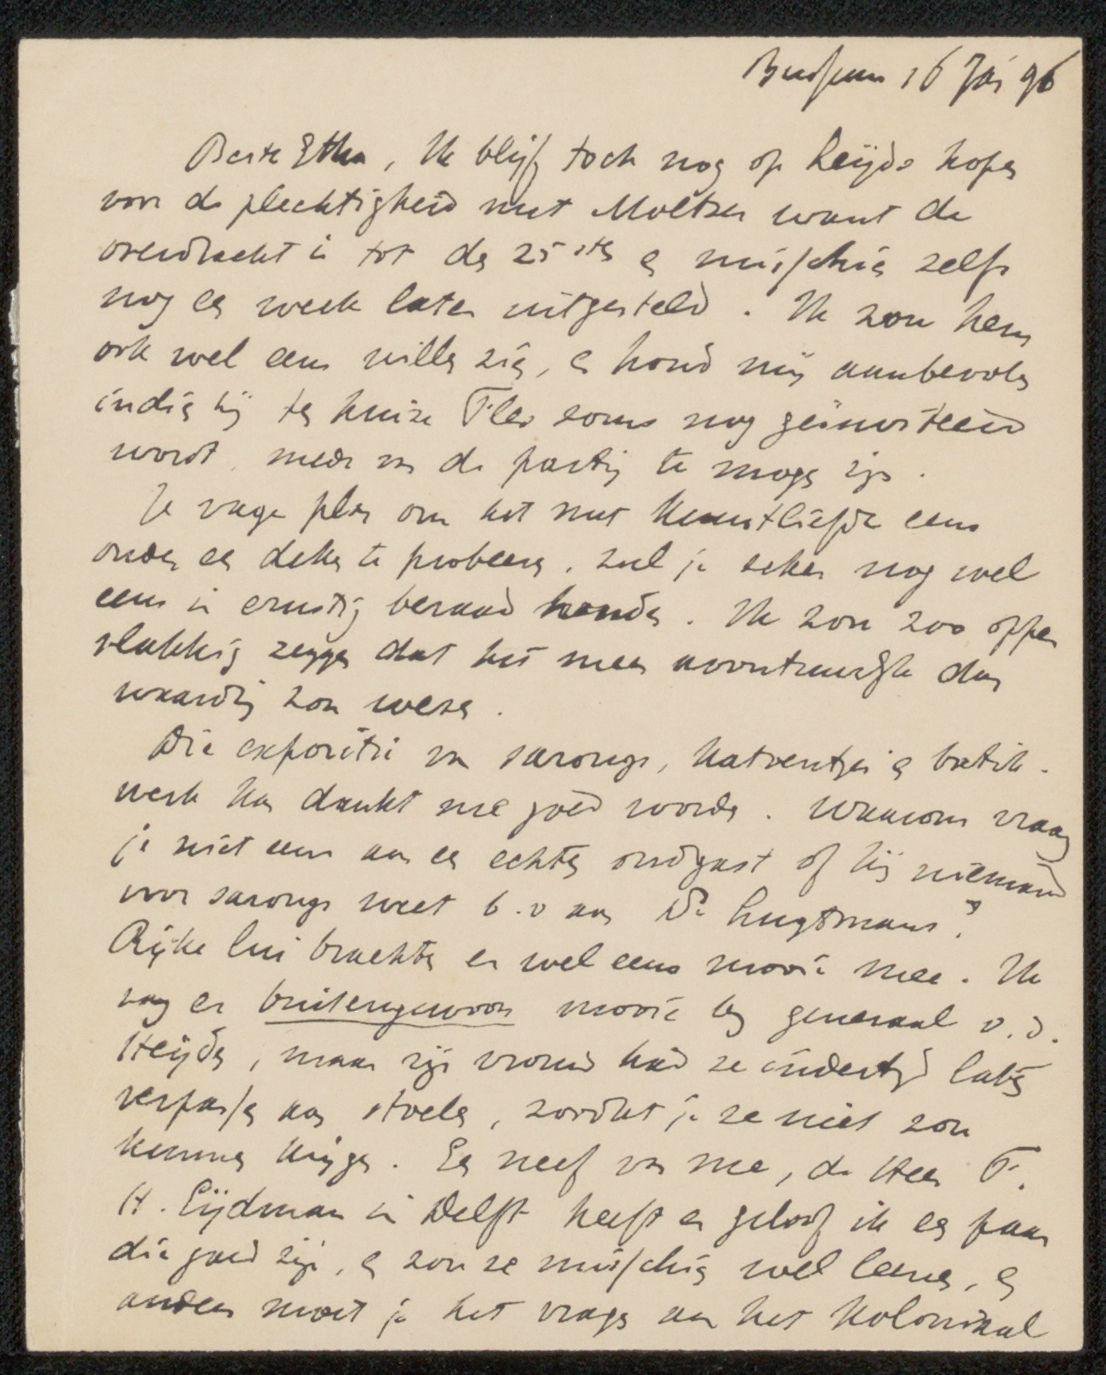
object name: letter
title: Brief aan Etha Fles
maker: jan veth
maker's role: designer, draughtsman, painter, print maker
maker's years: 1864-1925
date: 1896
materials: cardboard, ink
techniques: pen, writing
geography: bussum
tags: utrecht, print maker, etha fles, haarlem, applied arts, arts and crafts; industrial design, exhibition ~ art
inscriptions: collector's mark: ‘RPK’